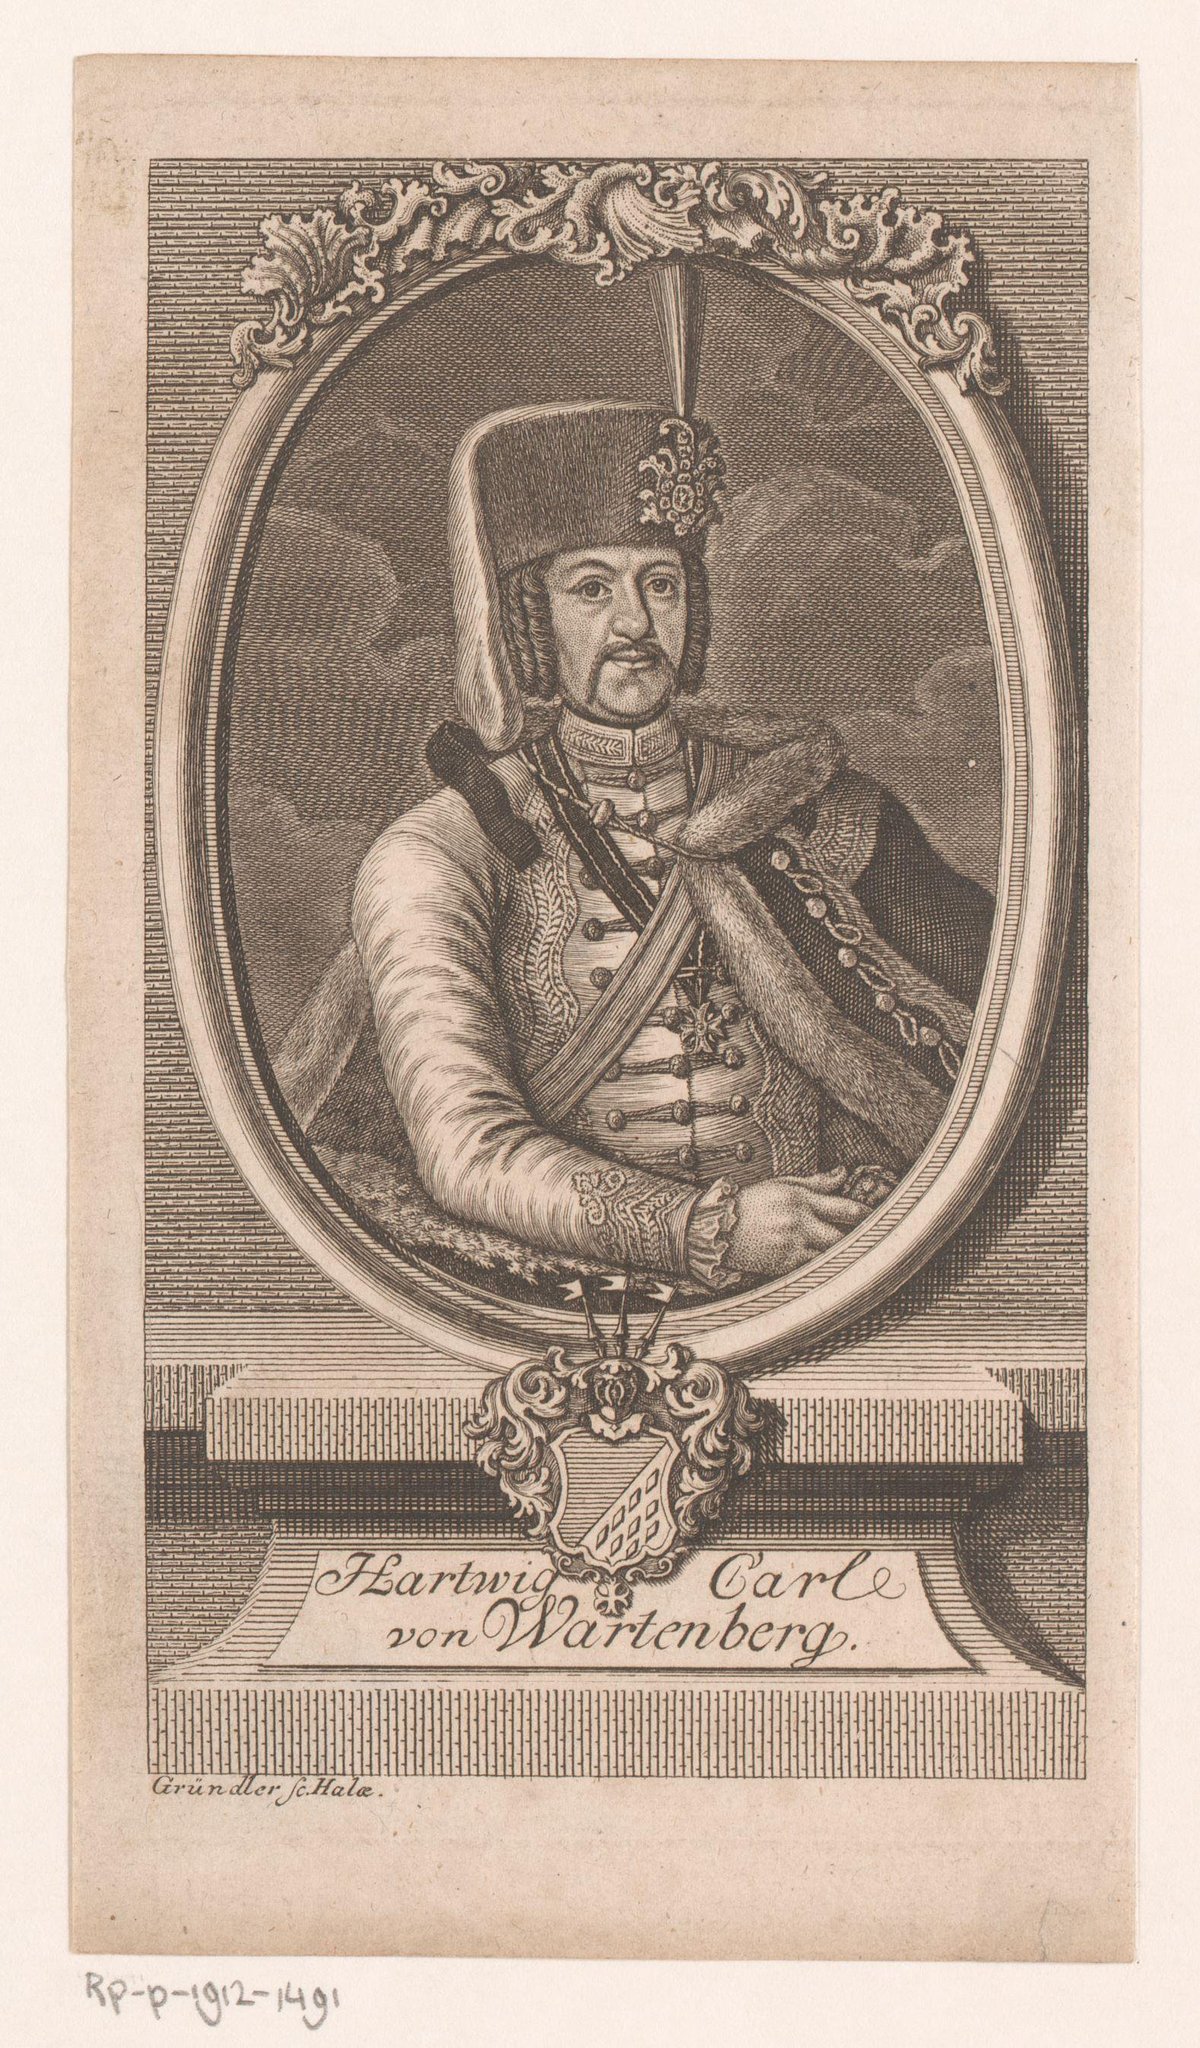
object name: print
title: Portret van Hartwig Karl von Wartenberg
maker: gottfried august gründler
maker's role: painter, print maker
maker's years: 1710-1775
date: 1721-1757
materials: paper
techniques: engraving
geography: halle an der saale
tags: rocaille ornament, knighthood order, commander-in-chief, general, marshal, historical persons, armorial bearing, heraldry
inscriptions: collector's mark: Lugt 2228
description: Prent gebruikt voor: Pauli, Carl Friedrich. Leben grosser Helden des gegenwärtigen Krieges. Halle an der Saale: Christoph Peter Francke, 1759.